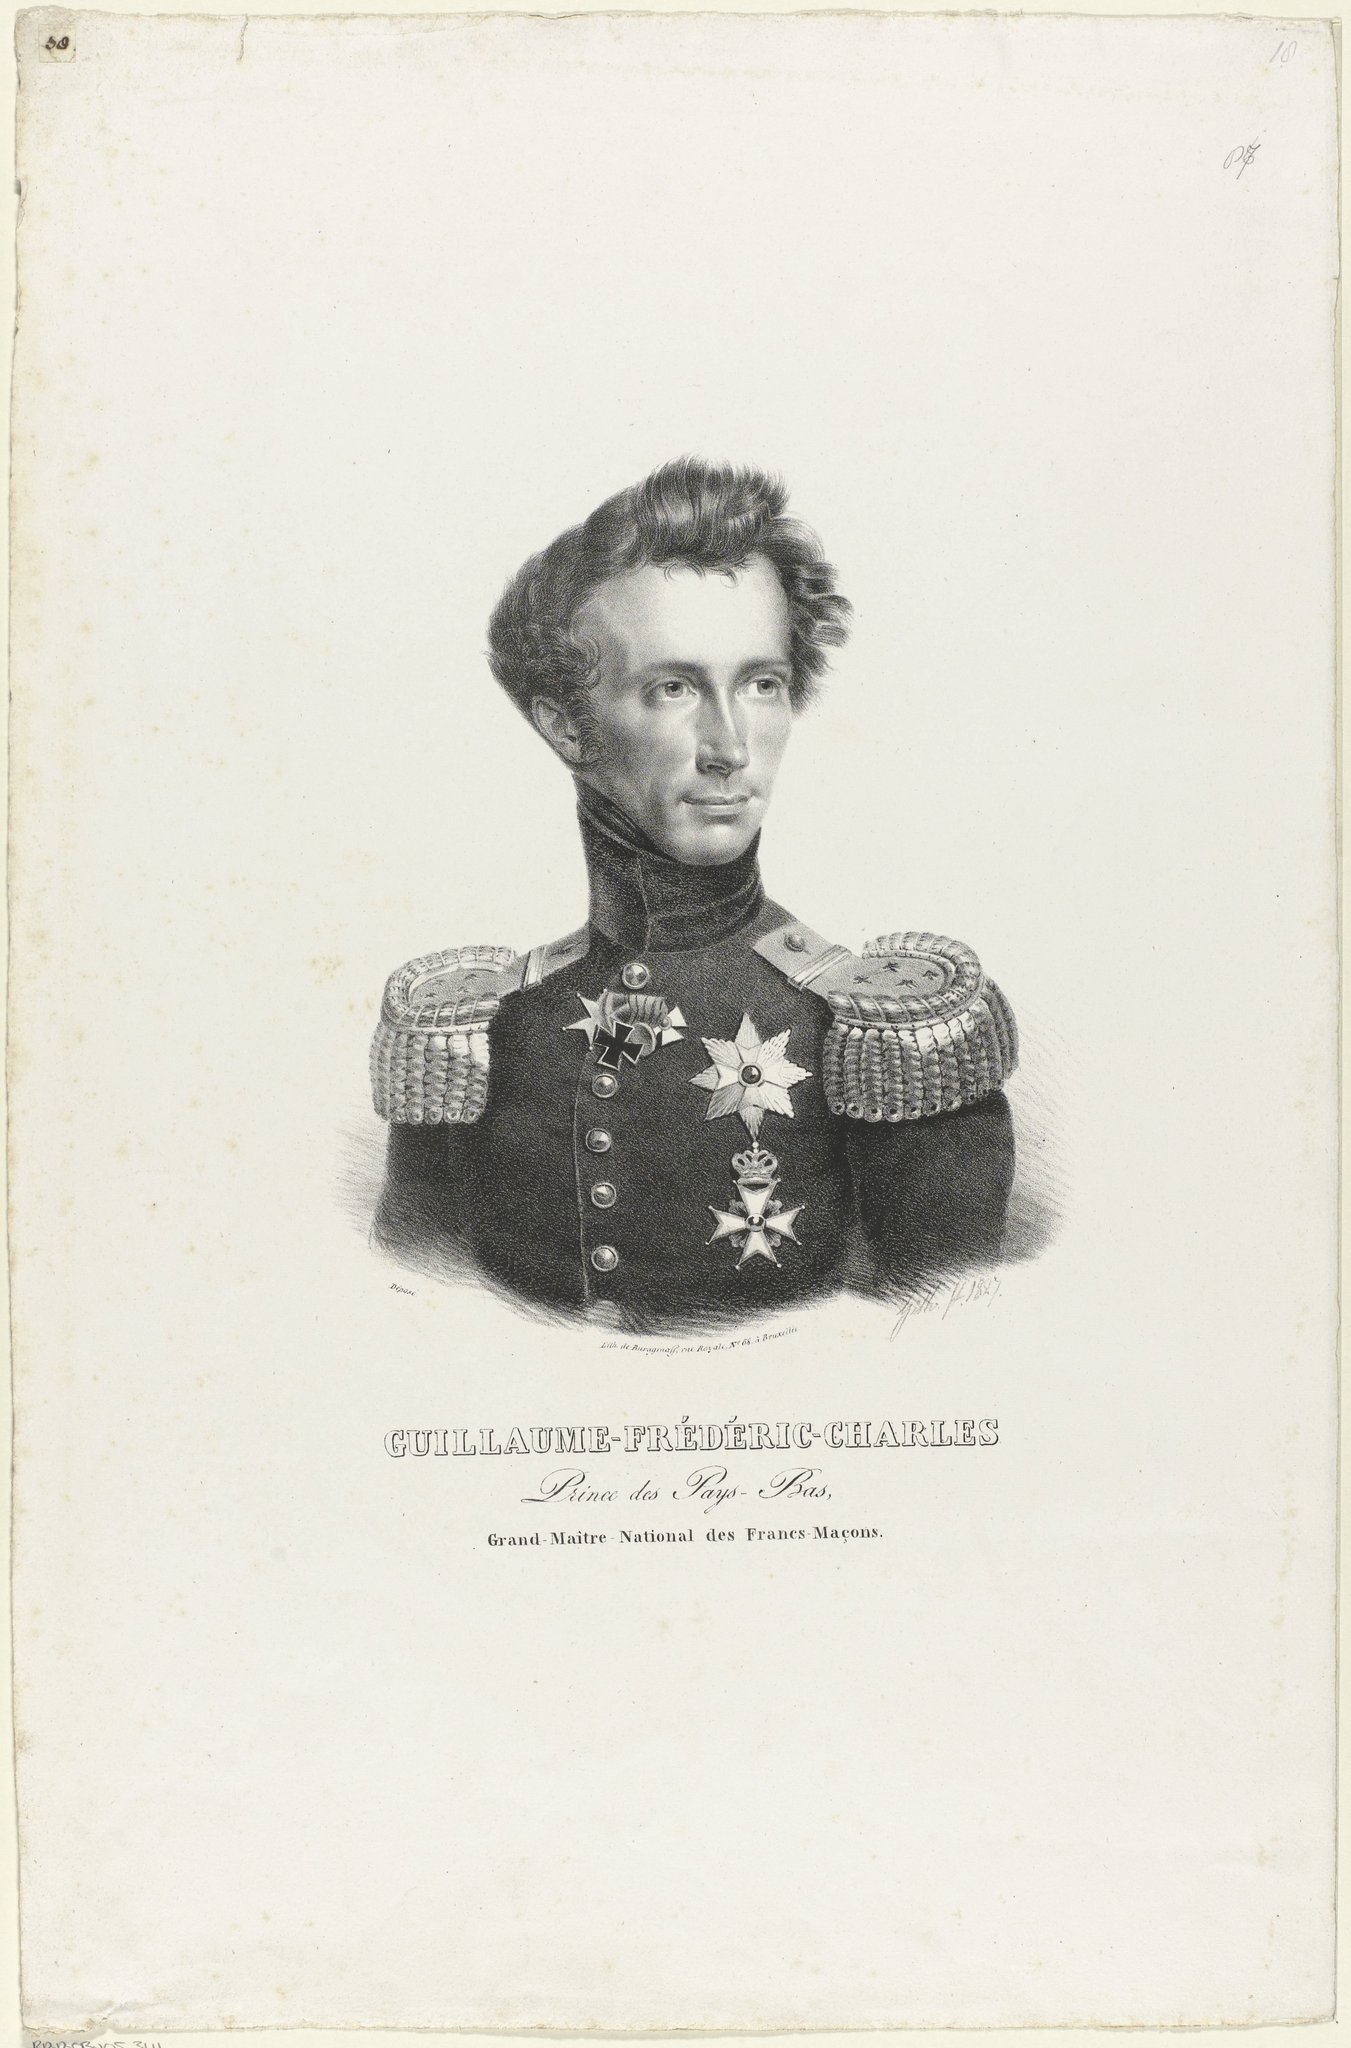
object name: print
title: Portret van Frederik, prins der Nederlanden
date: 1827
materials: paper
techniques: lithograph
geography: brussels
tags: berlin, frederik (prins der nederlanden)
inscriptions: octrooivermelding, gedrukt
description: De hier vermelde titel verwijst naar de hoogst verkregen titel van de geportretteerde, niet per se naar de titel die de geportretteerde op deze voorstelling draagt.